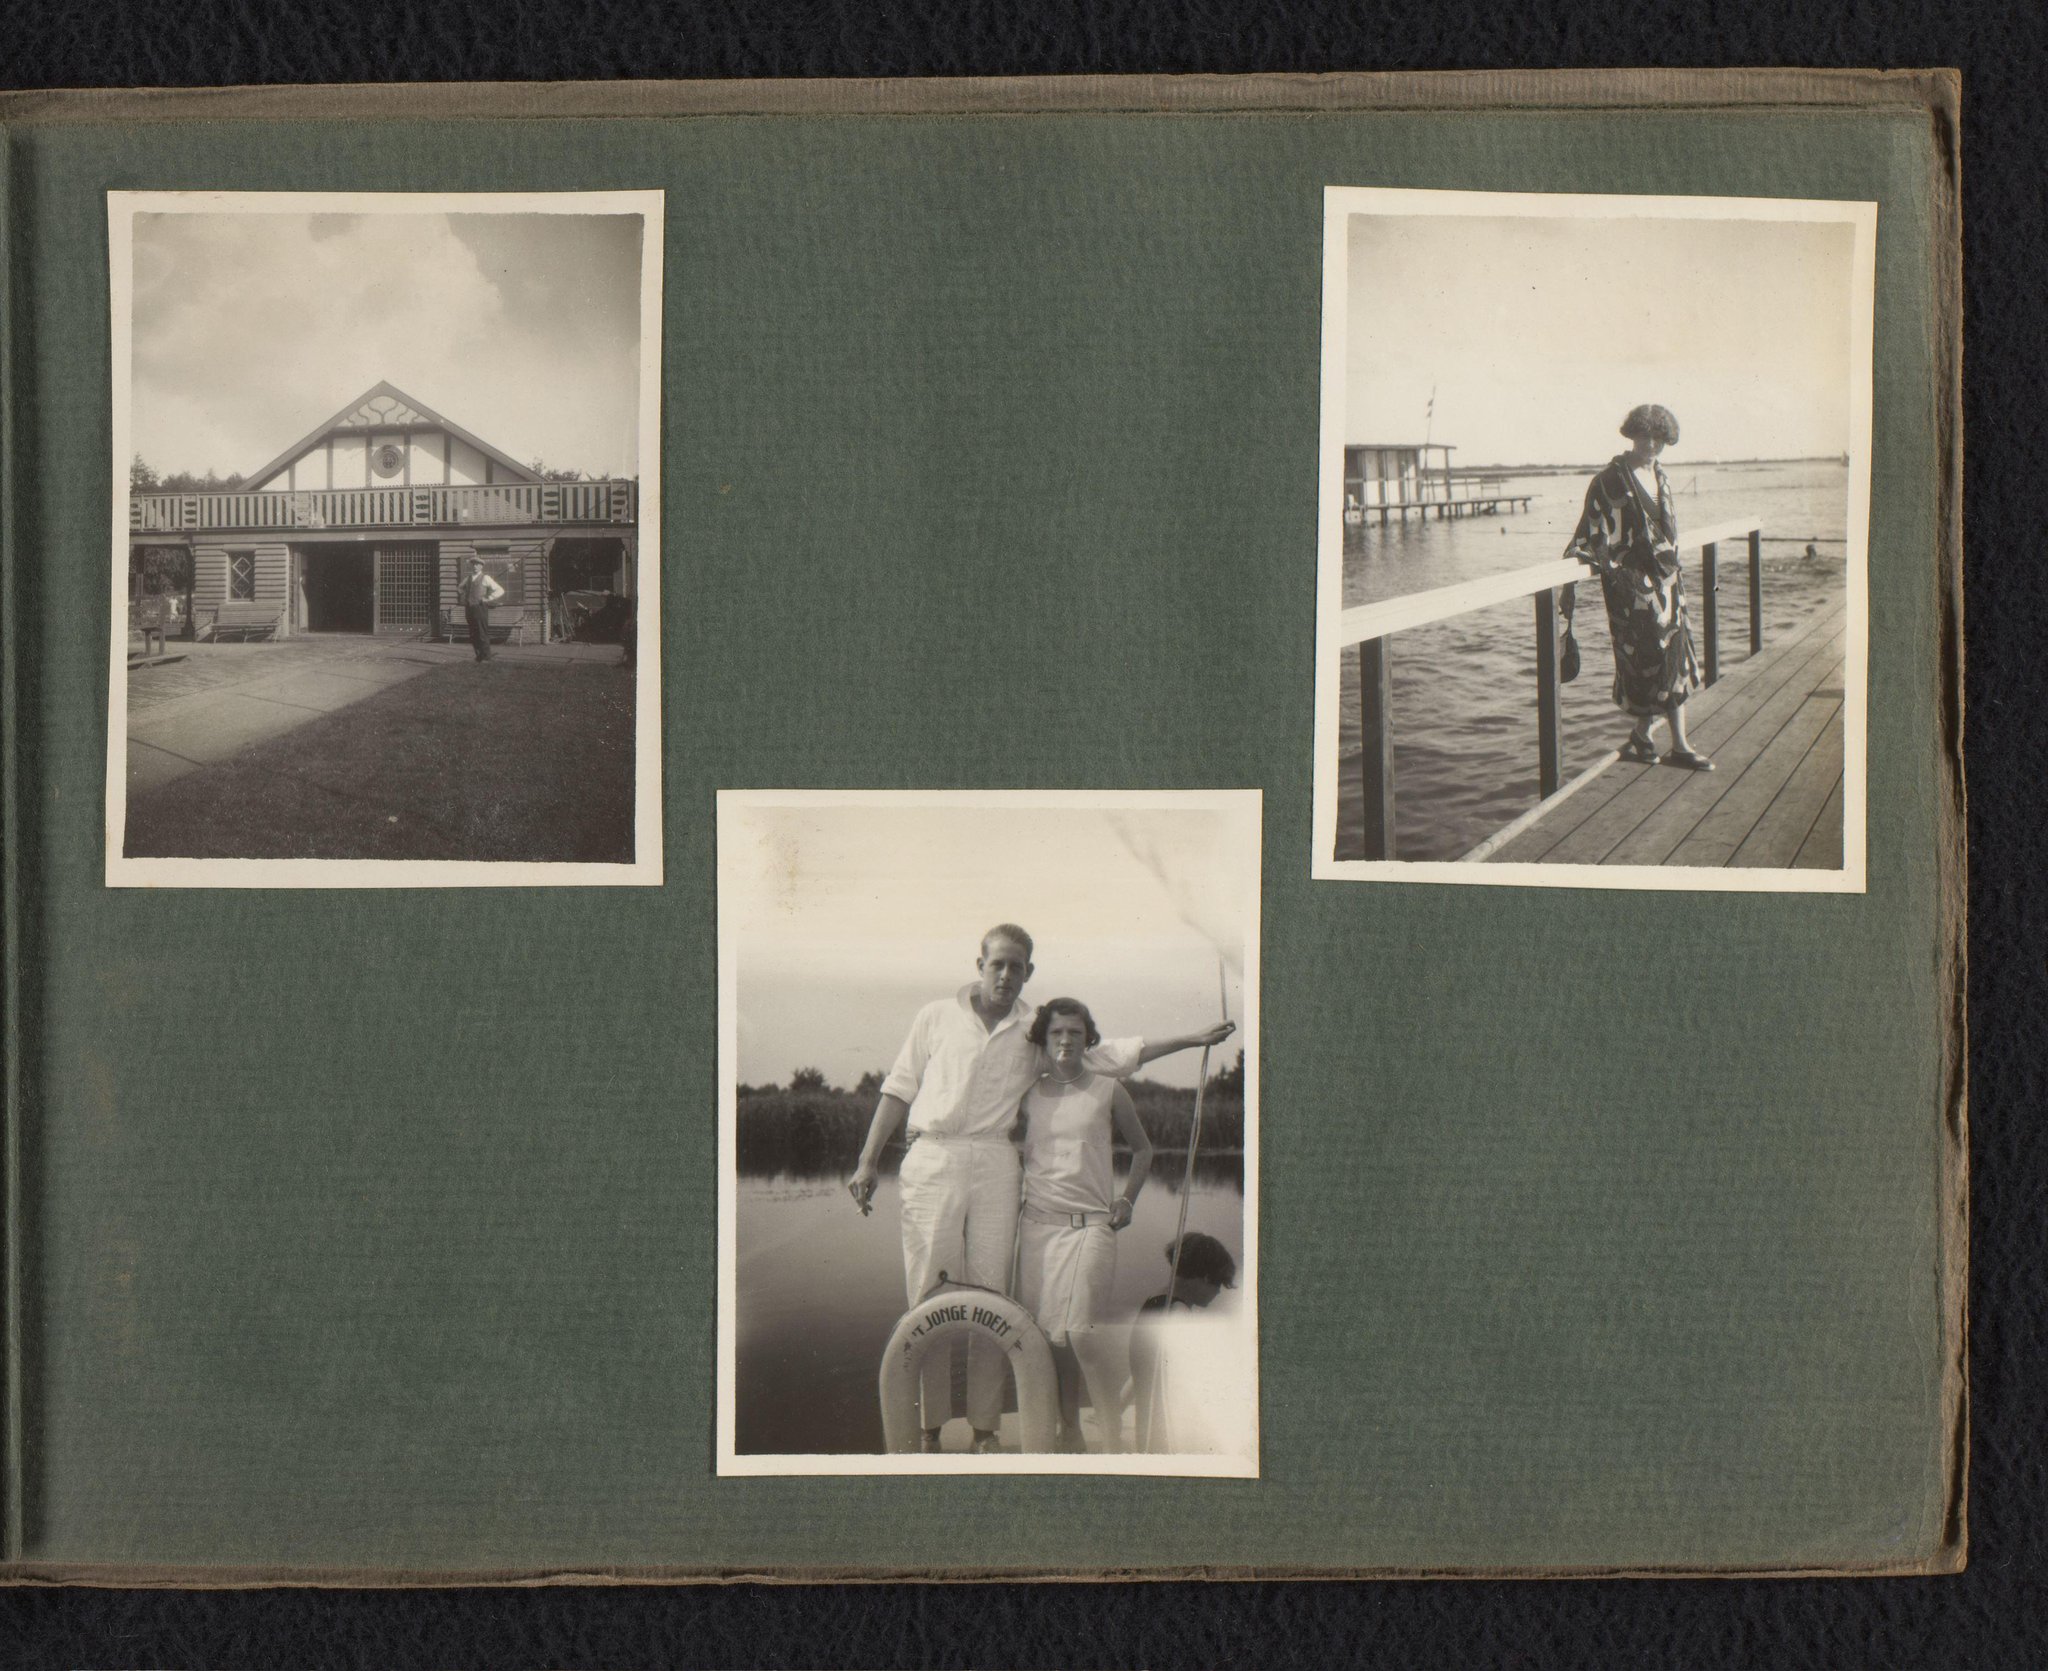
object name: album leaf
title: Drie foto's van een gebouw, een man en vrouw op een boot en een vrouw aan een steiger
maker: Anonymous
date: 1920-1930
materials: paper, cardboard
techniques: gelatin silver print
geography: netherlands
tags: historical persons - bb - woman, historical persons, pier, quay, wharf, exterior ~ representation of a building, traffic on the water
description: Deze foto's maken deel uit van een album.